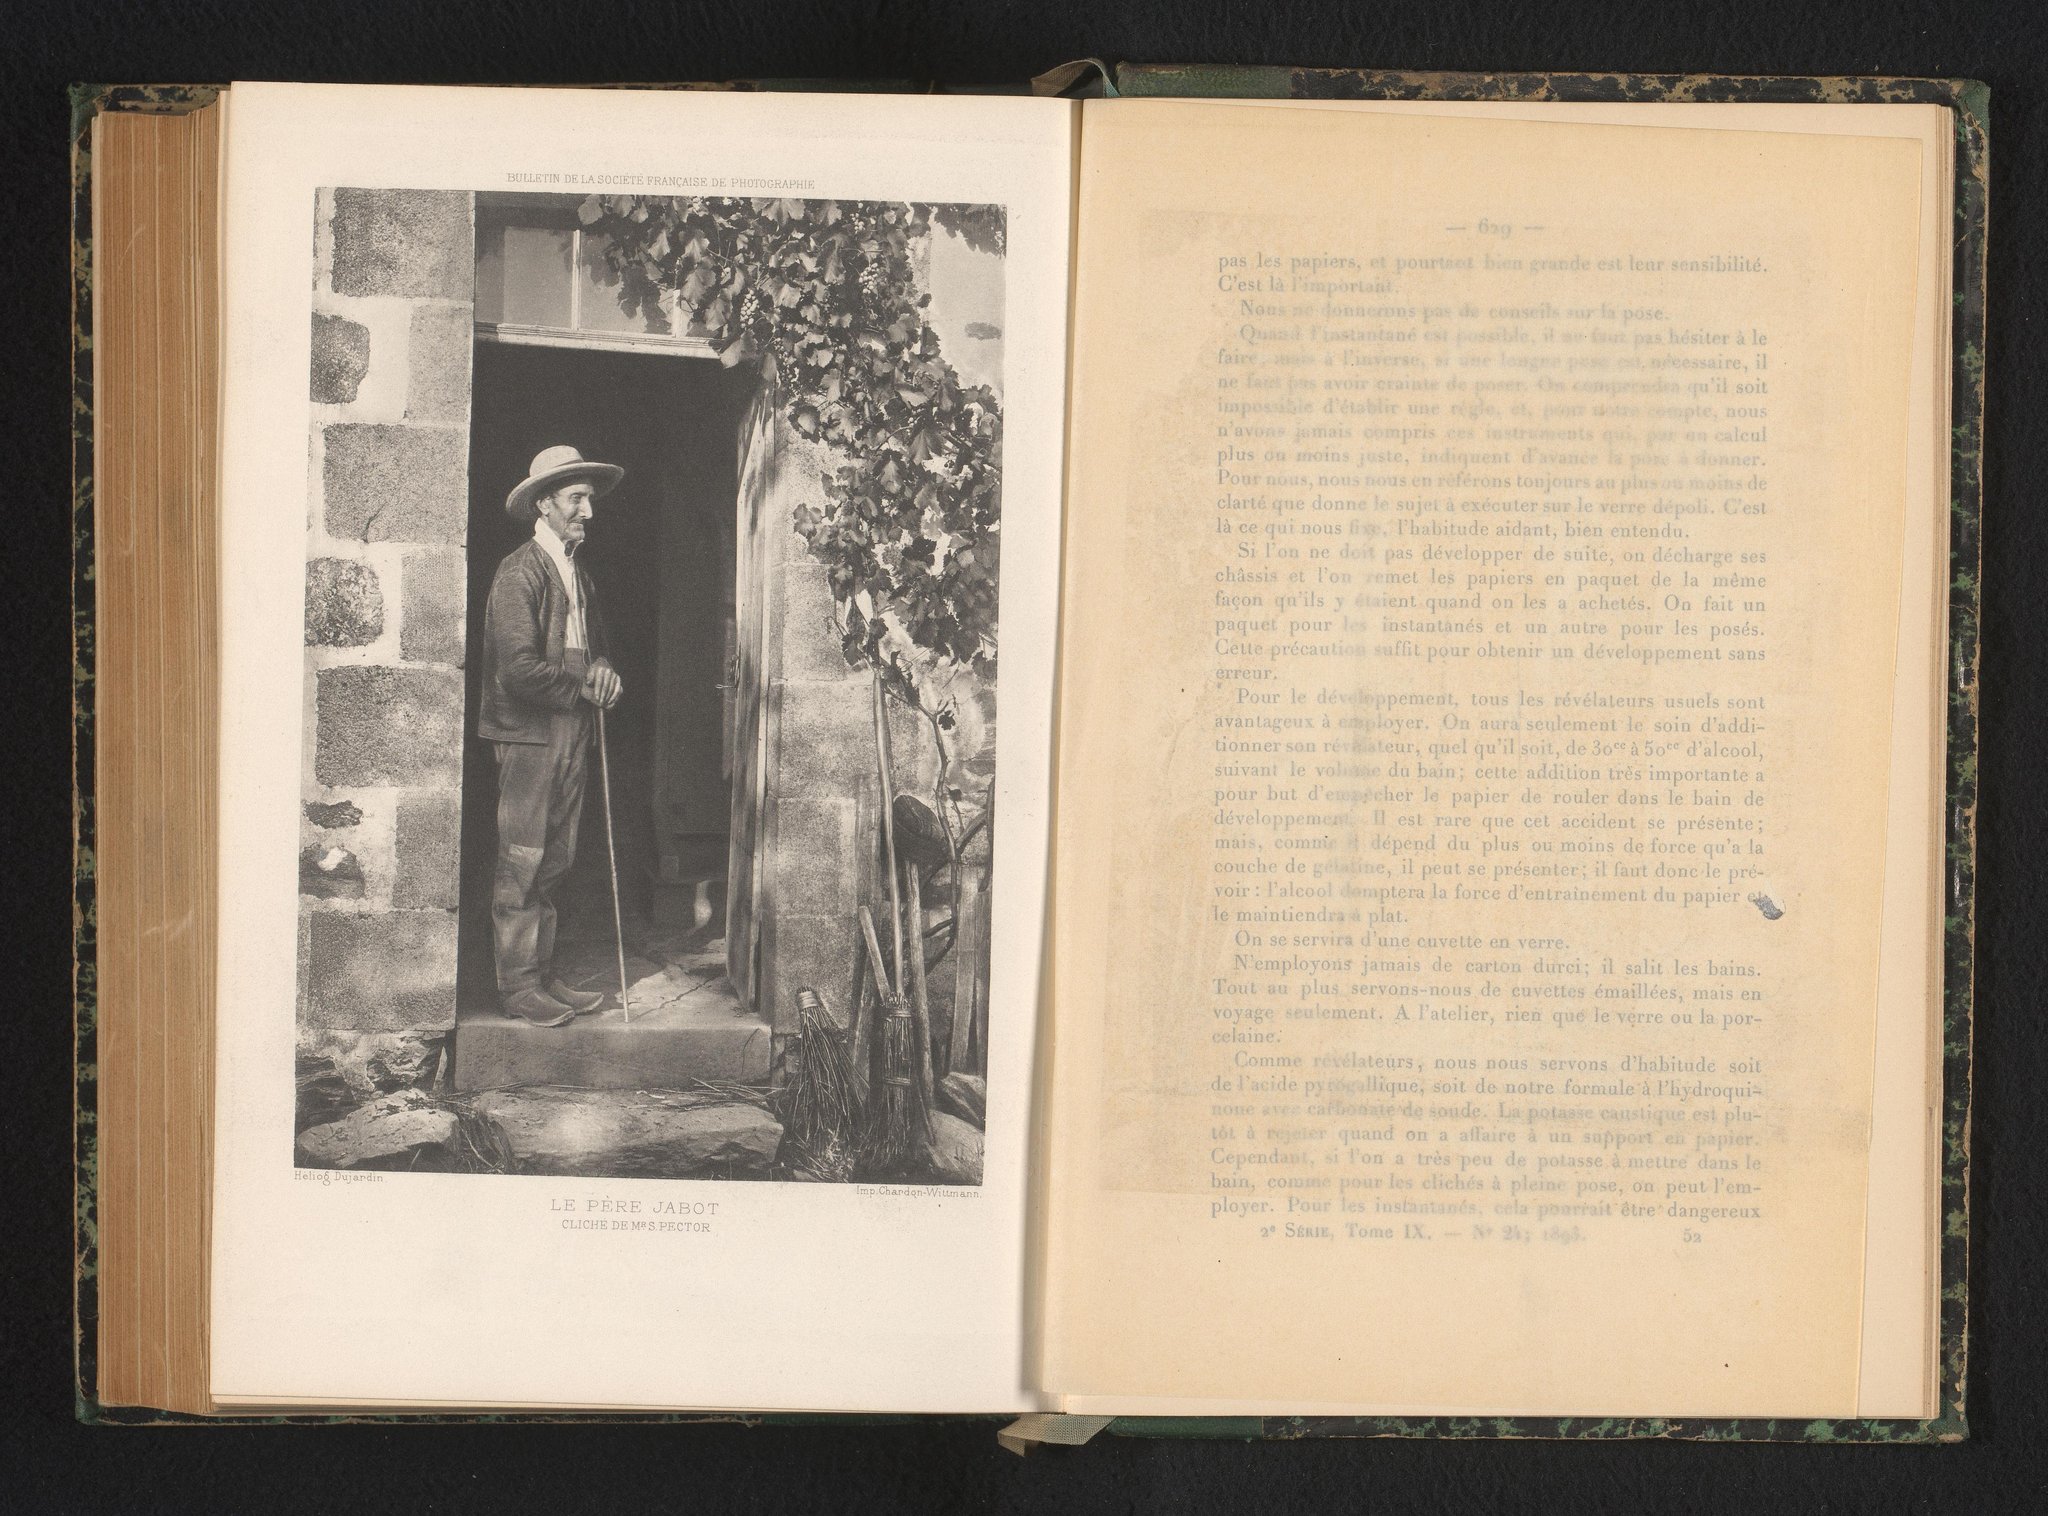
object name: page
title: Oude man in een deuropening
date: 1892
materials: paper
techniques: photoaquatint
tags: old man, opening the door